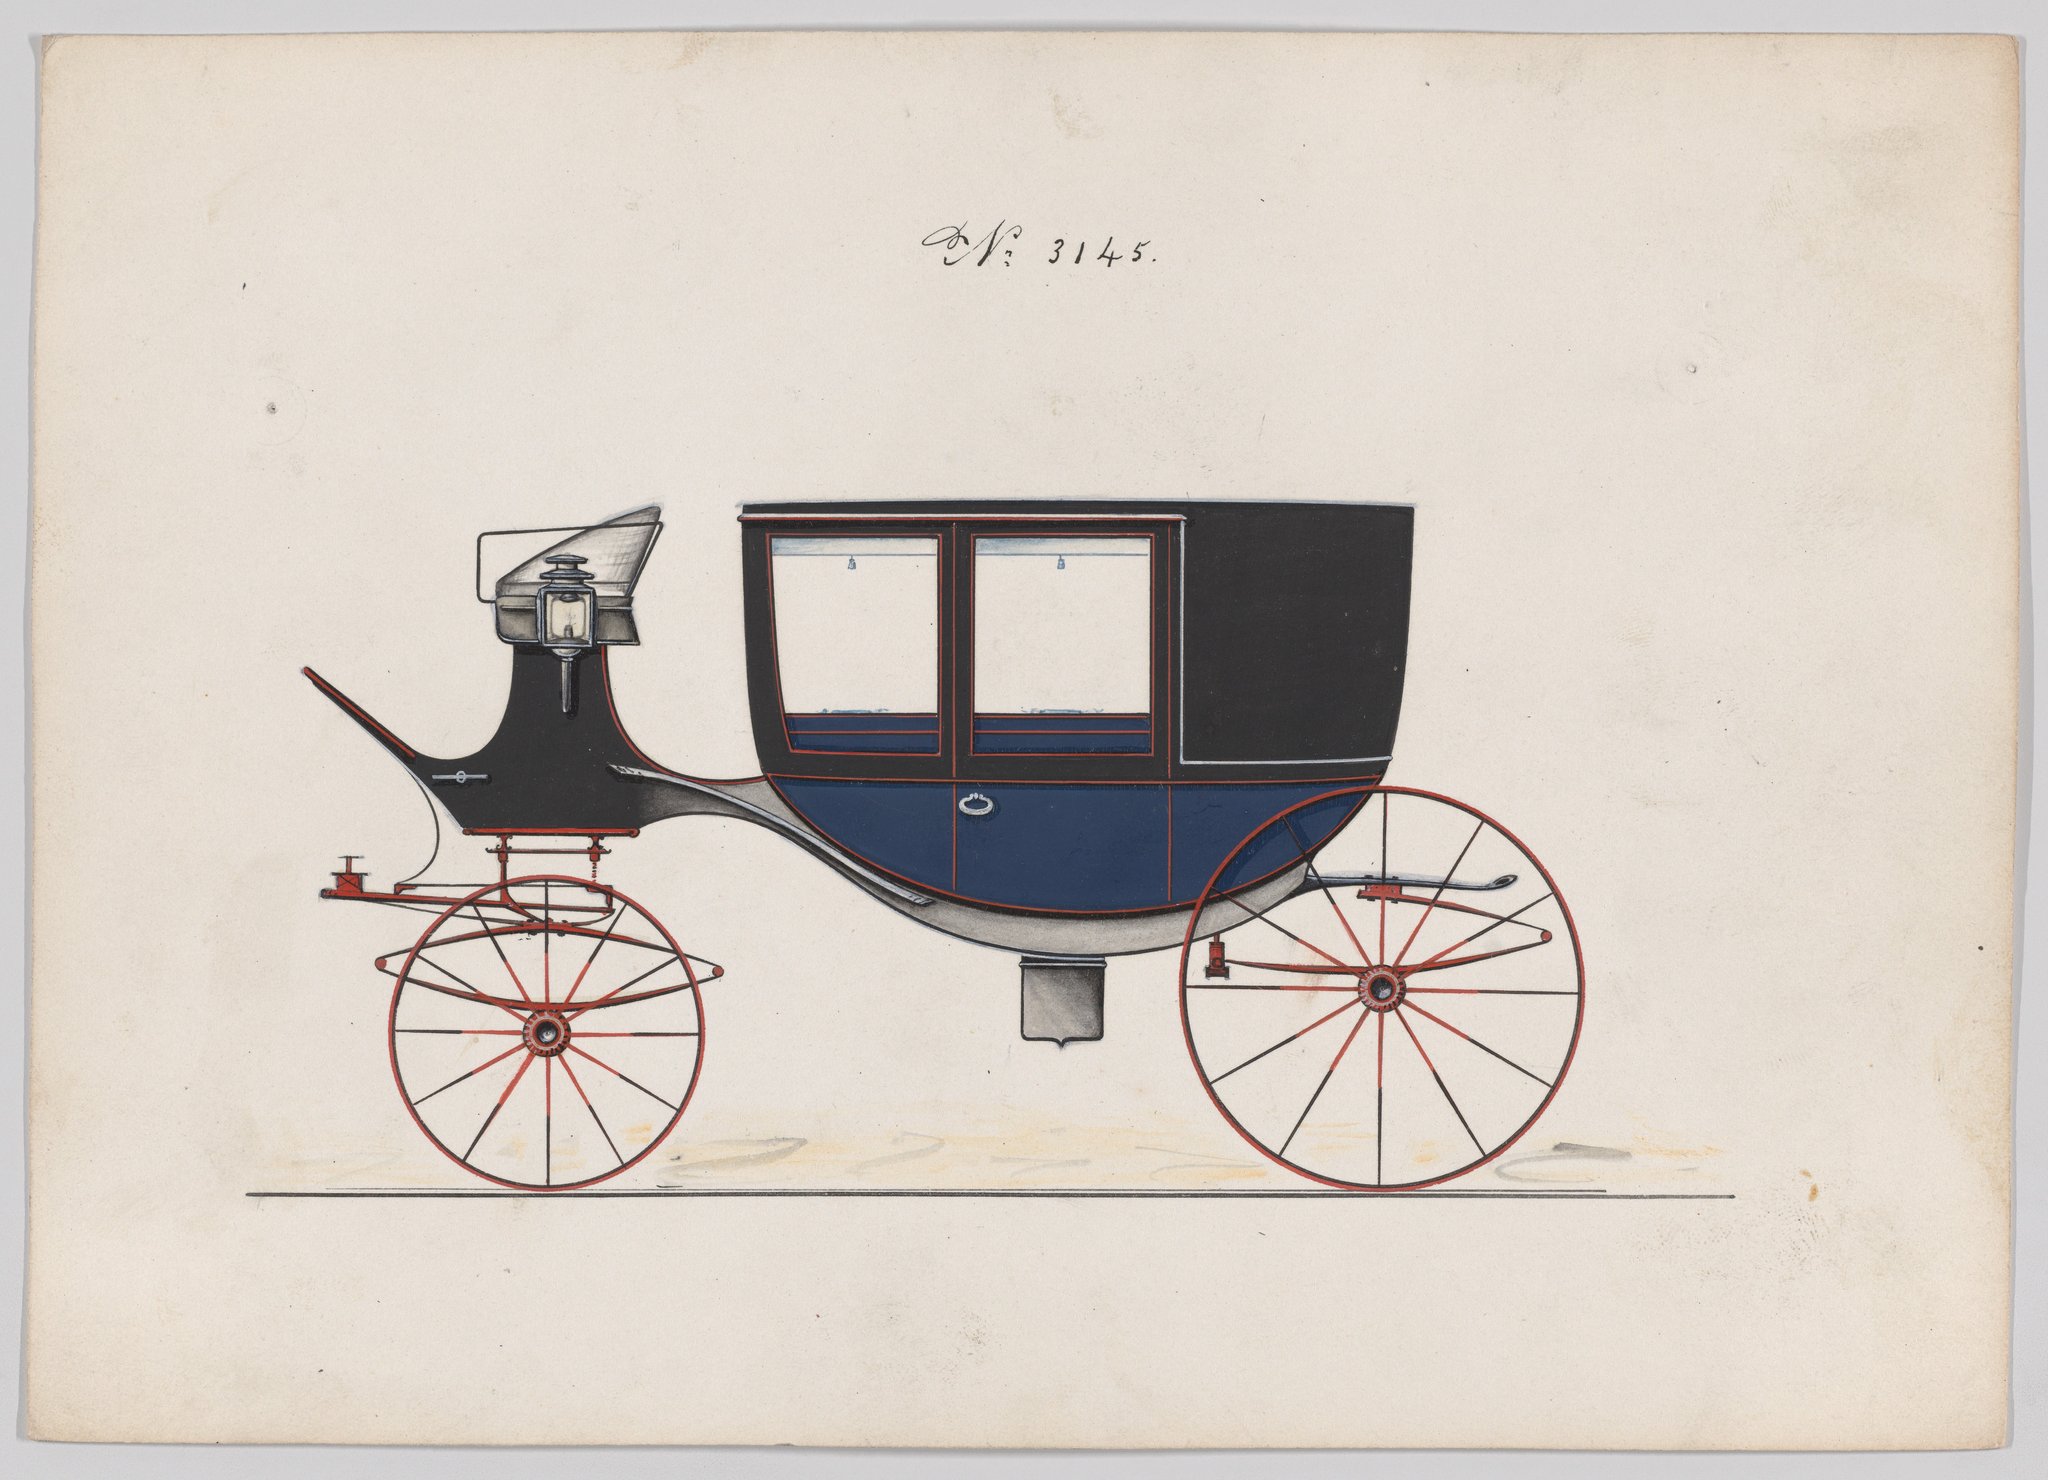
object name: drawing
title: Coach #3145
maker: brewster & co.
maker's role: manufacturer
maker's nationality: american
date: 1875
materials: gouache, gum arabic, ink, watercolor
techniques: pen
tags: carriages